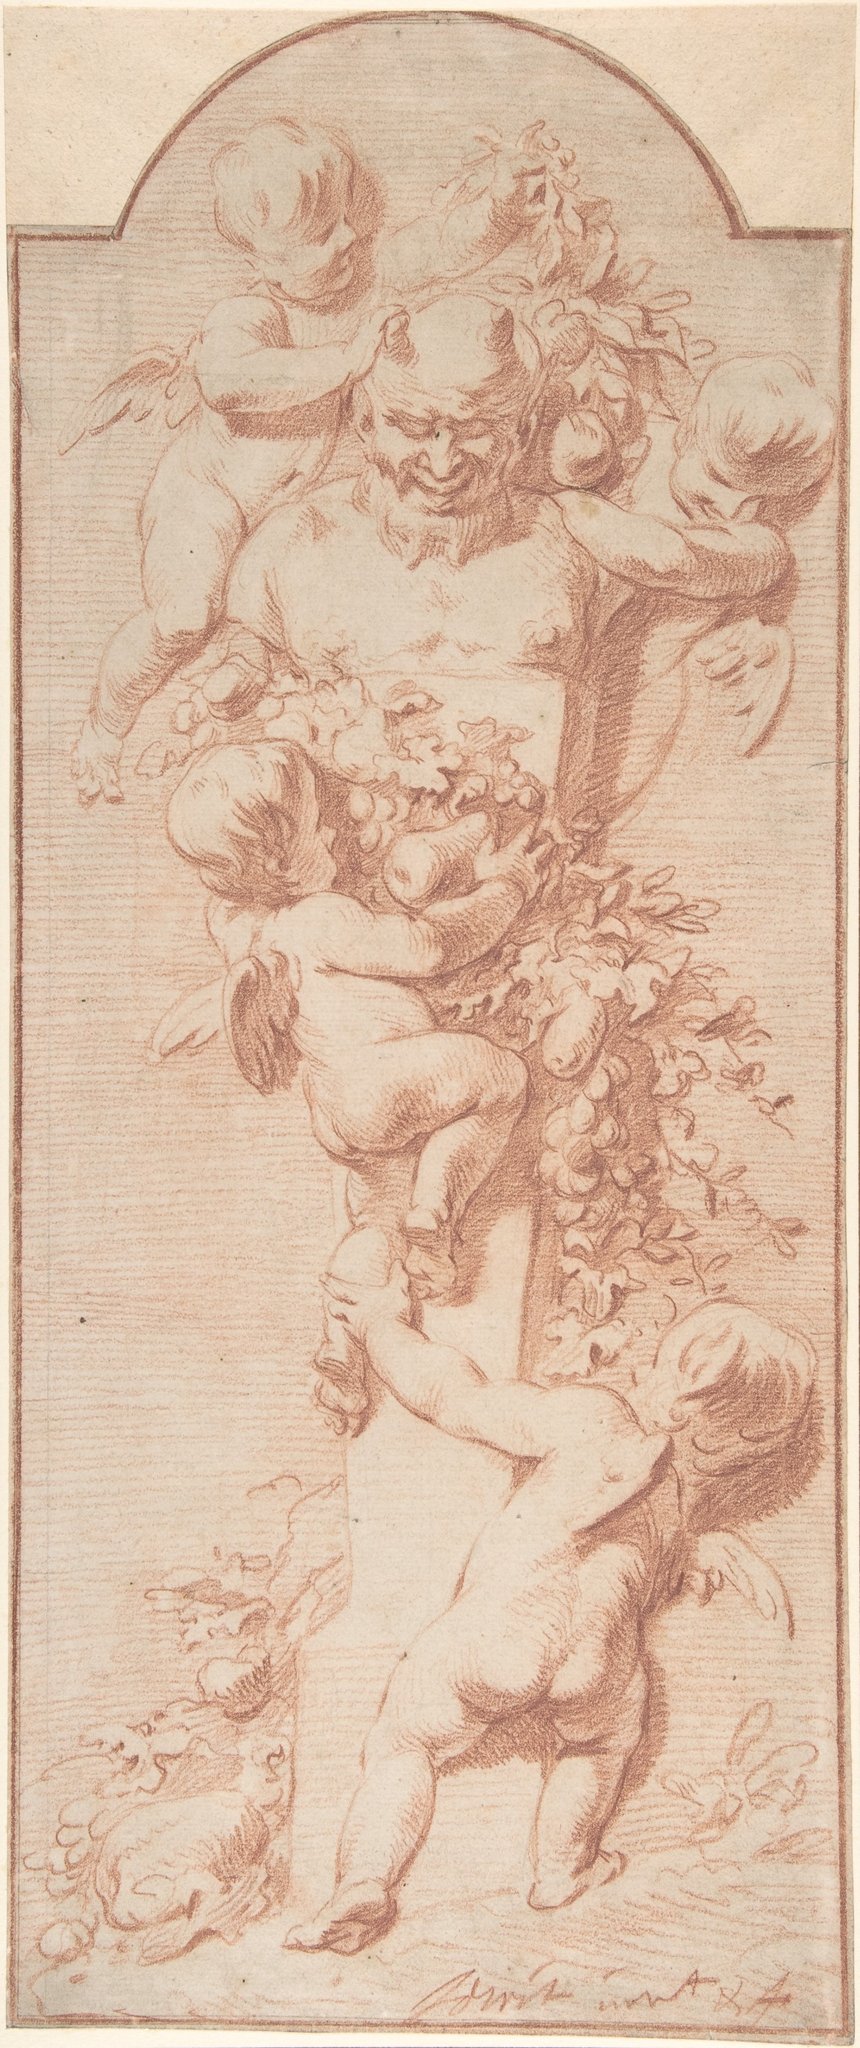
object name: drawing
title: Design for a Panel with Four Putti Decorating a Herm (Terminal Figure) with Garlands of Fruit and Foliage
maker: jacob de wit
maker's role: artist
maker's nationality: dutch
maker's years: 1695-1754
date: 1720-1740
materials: chalk, gold, paper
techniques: inlay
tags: ornament,fruit,putti